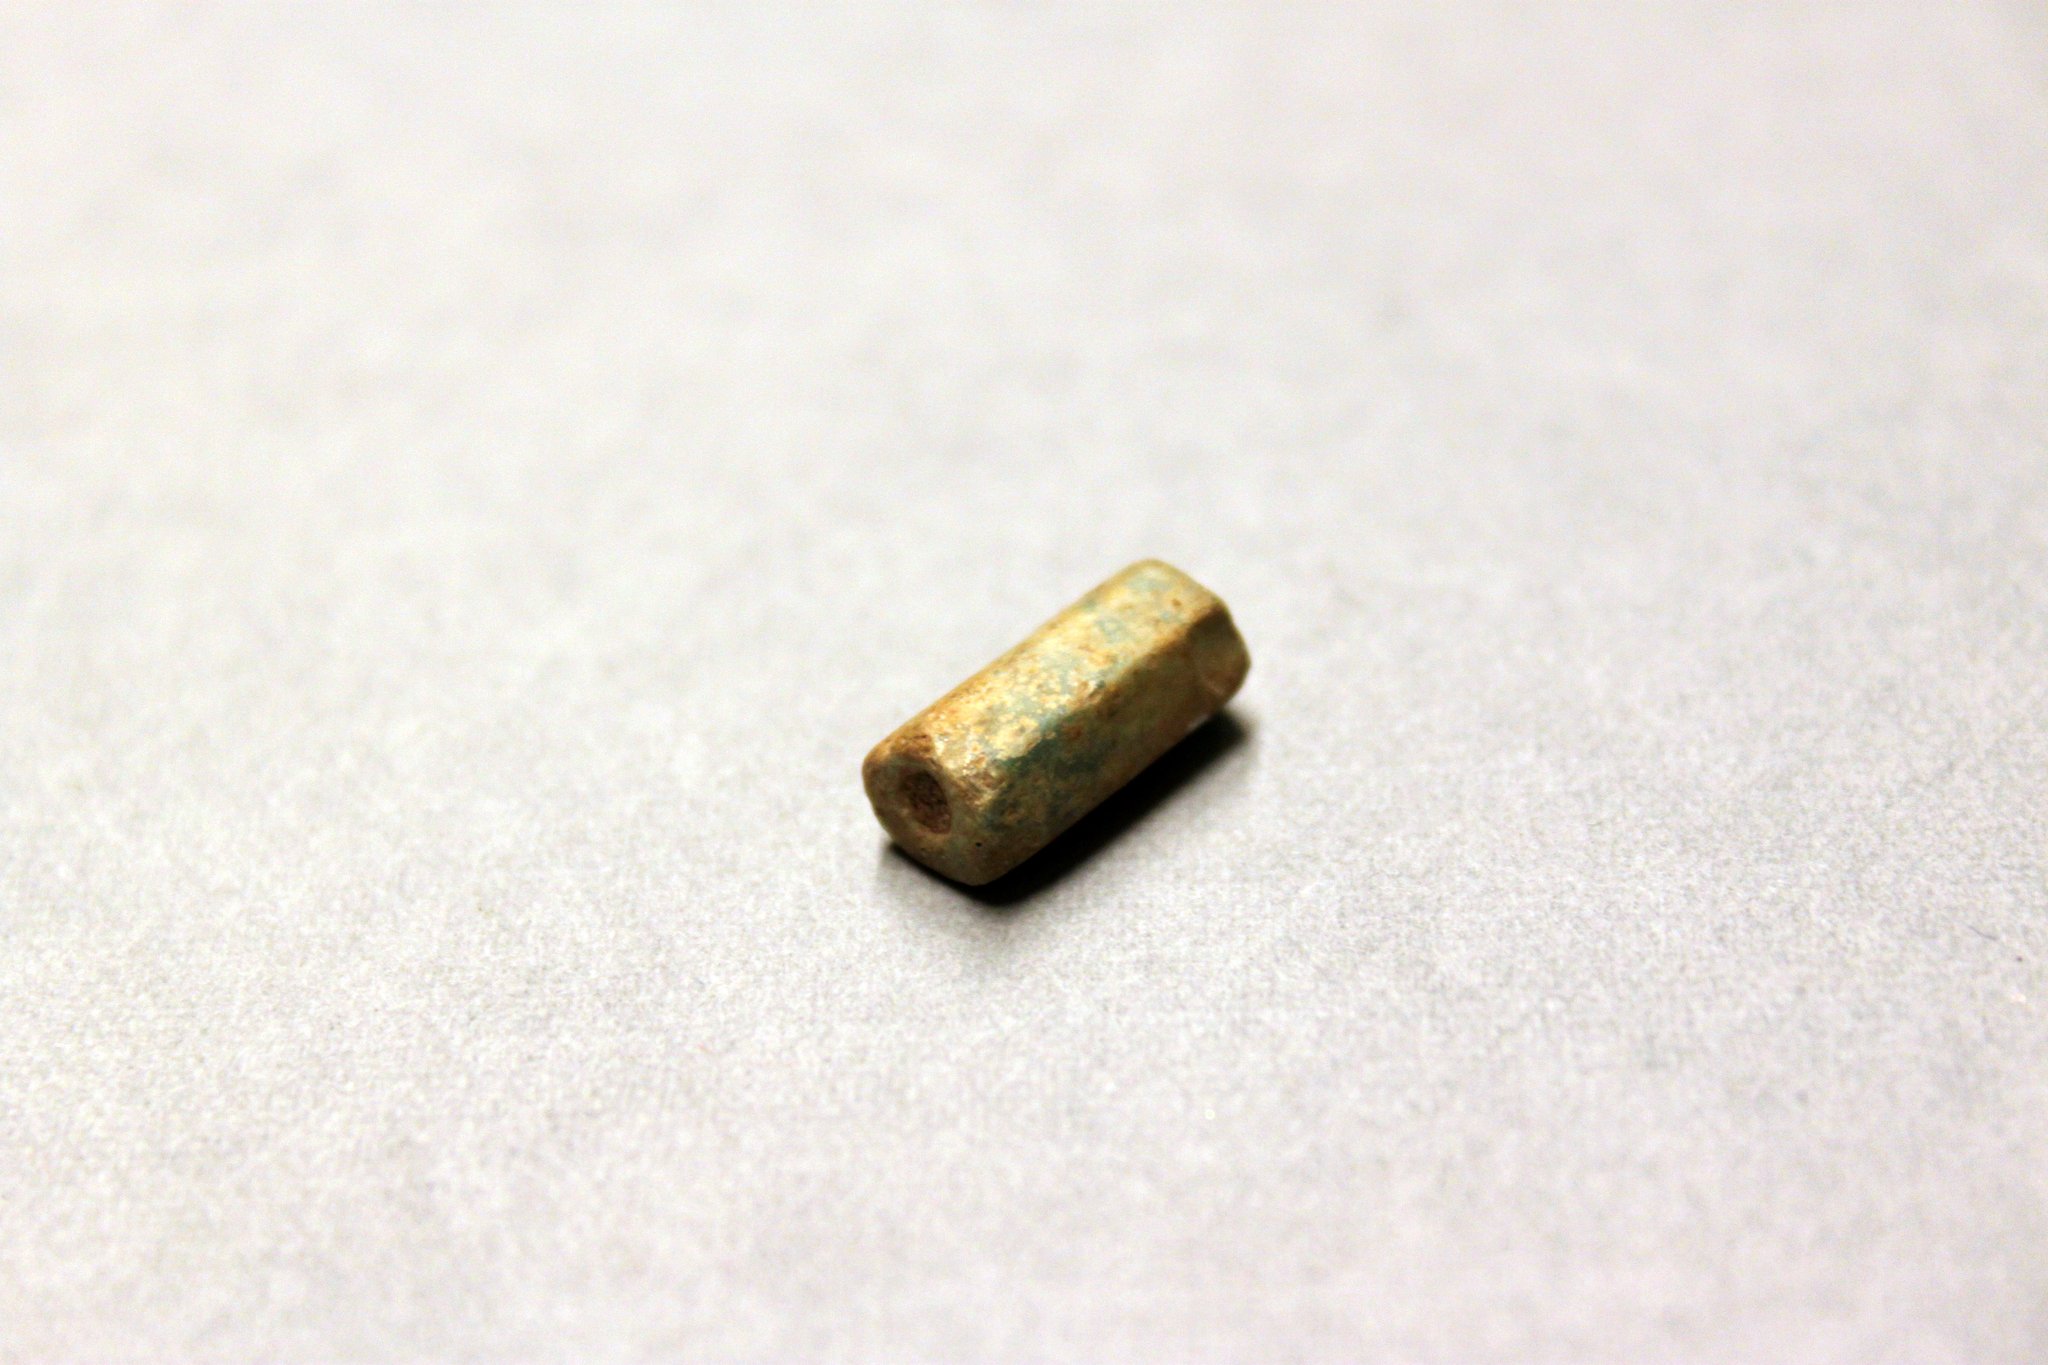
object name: bead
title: Beads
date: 701-1300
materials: glass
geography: iran